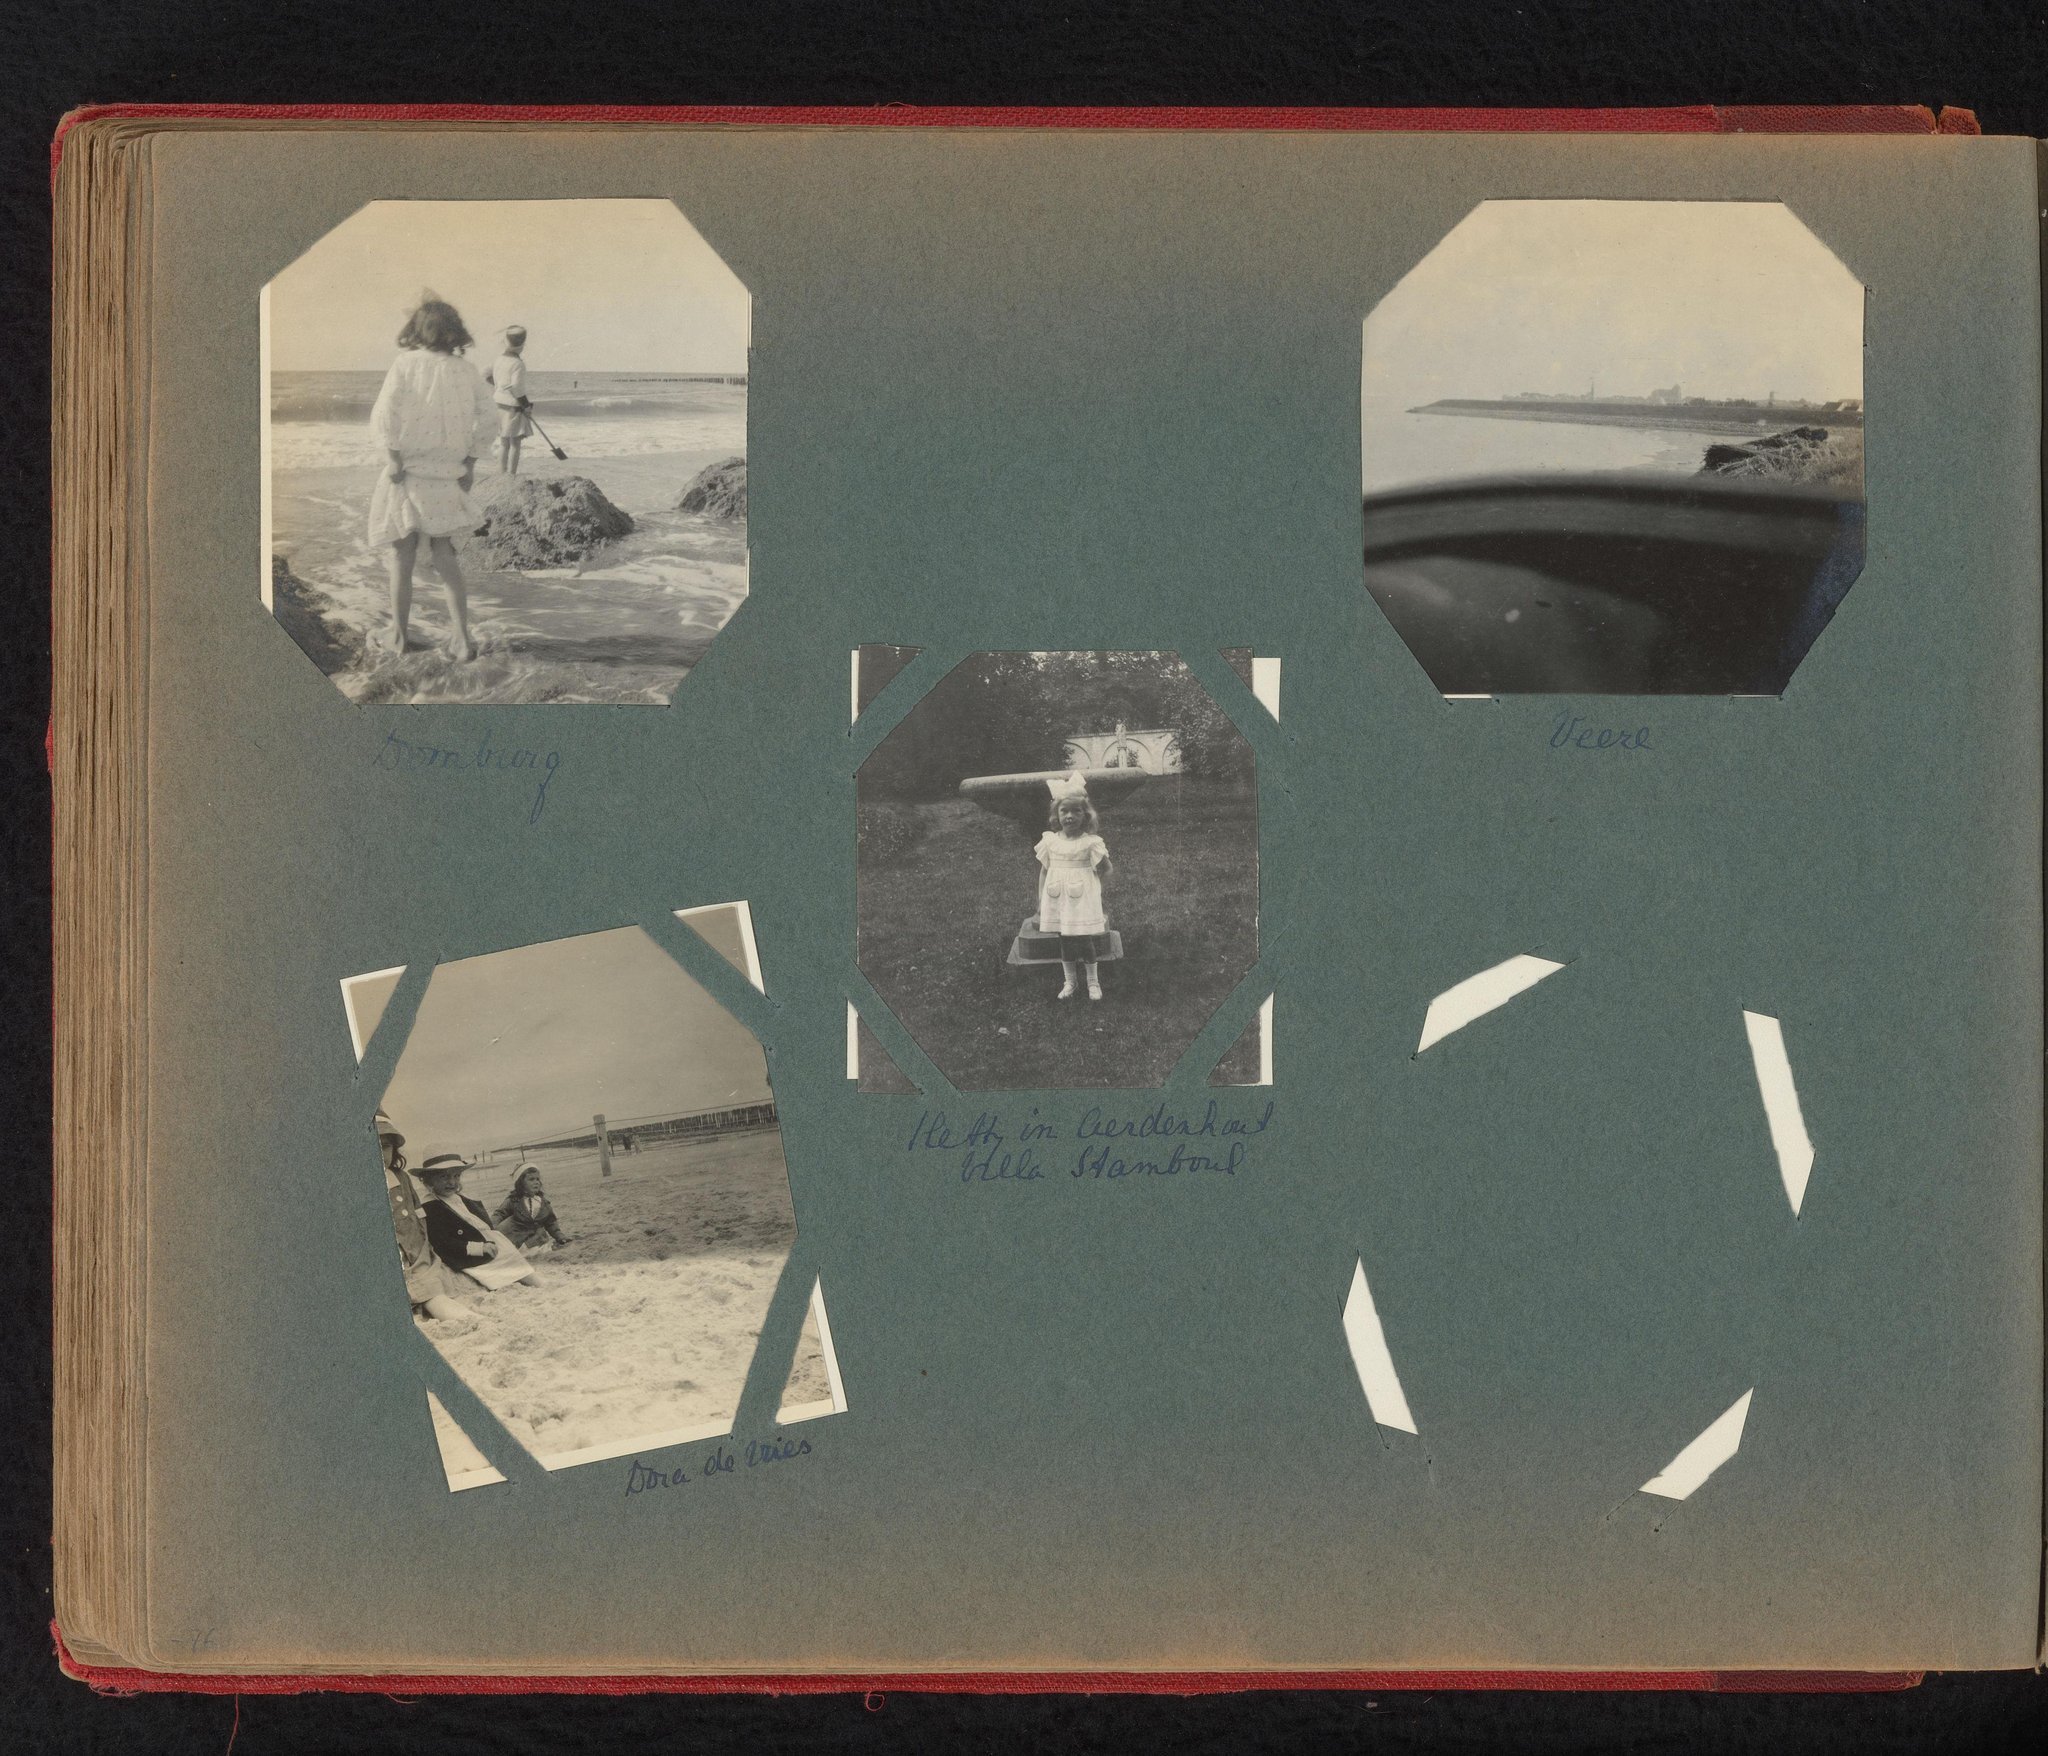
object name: album leaf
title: Hetty Boelen op het strand van Veere en Domburg, en in de tuin van Villa Stamboul in Aerdenhout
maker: charlotte alida boelen-matthes (lot)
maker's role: amateurfotograaf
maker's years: 1889-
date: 1917-1918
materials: paper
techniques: gelatin silver print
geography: netherlands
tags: beach (as place of recreation), garden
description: Villa Stamboul was vanaf 1901 het woonhuis van Marius Bauer en zijn vrouw Jo Bauer-Stumpff.